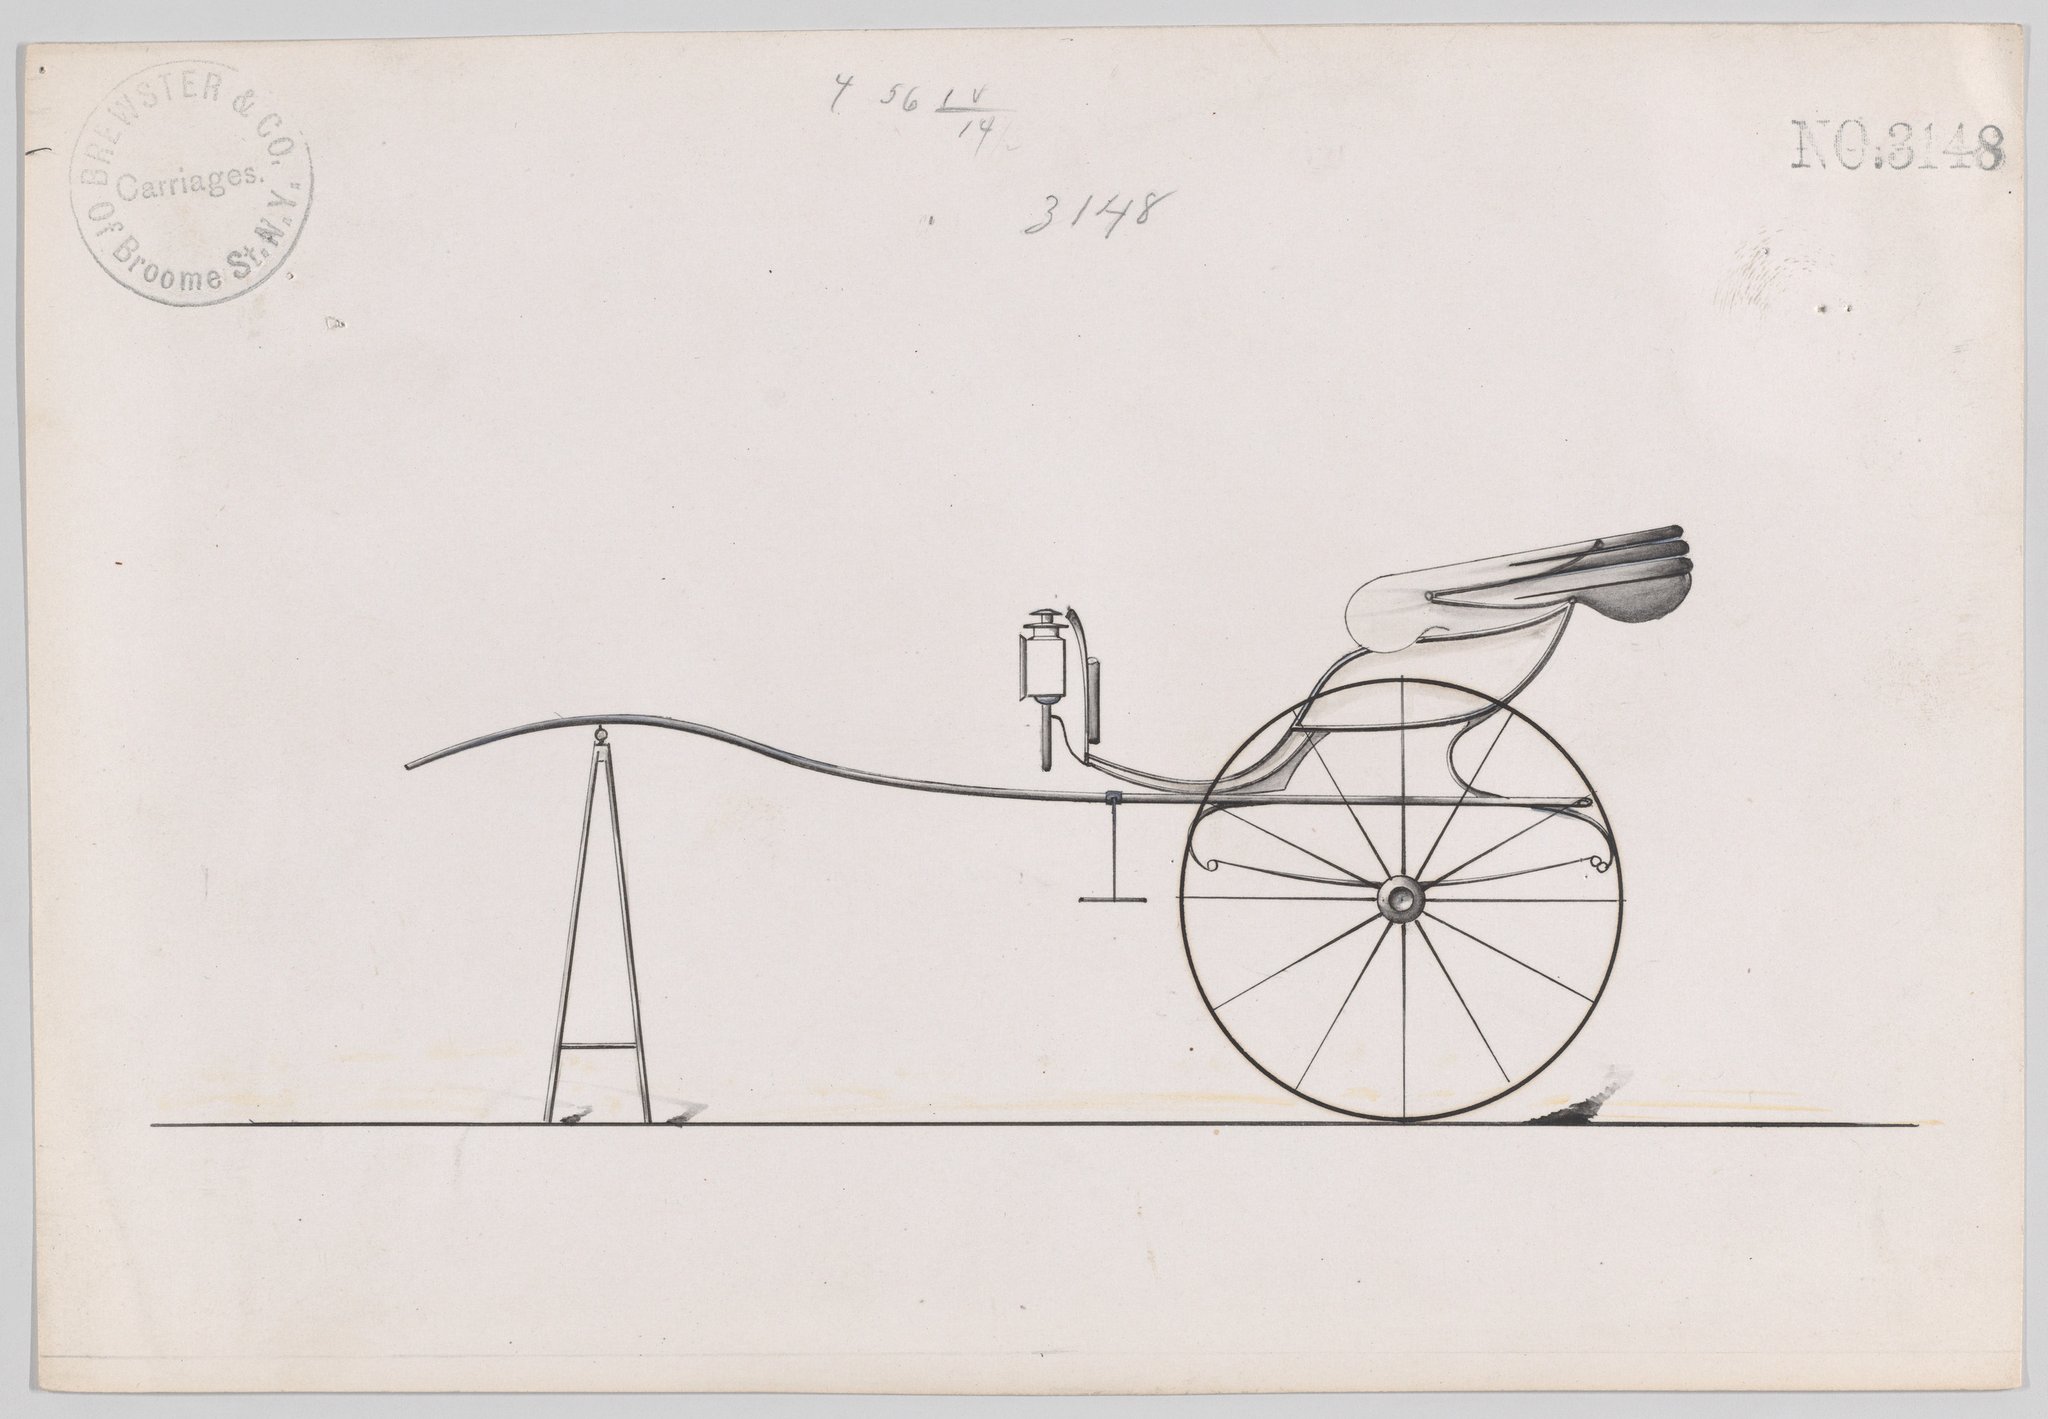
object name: drawing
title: Design for Dog Cart or 2 Wheeler, no. 3148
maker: brewster & co.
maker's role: manufacturer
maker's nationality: american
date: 1875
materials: gouache, gum arabic, ink, watercolor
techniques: pen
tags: carriages